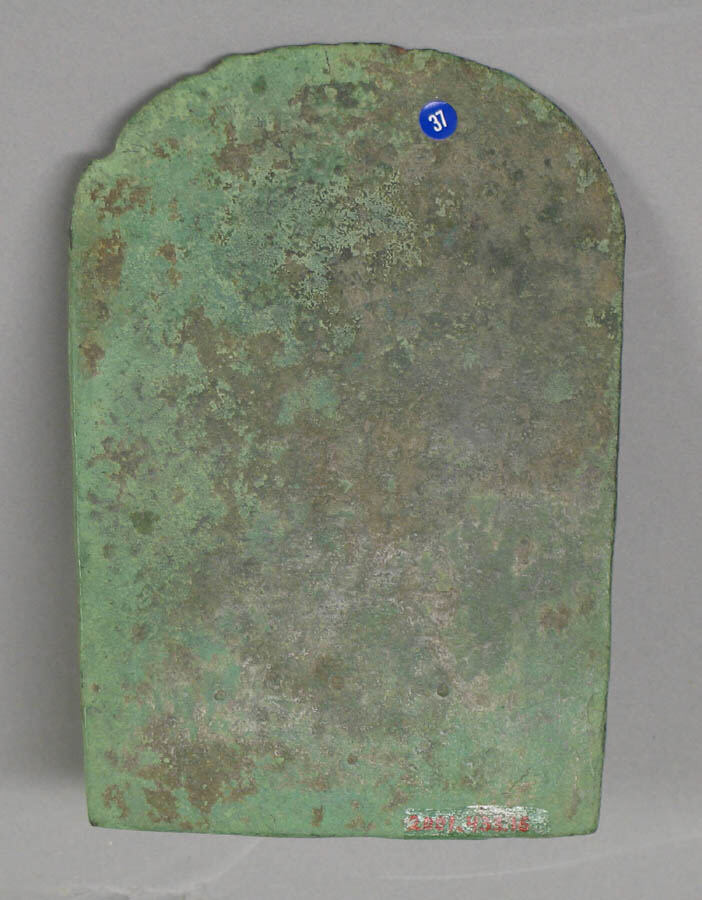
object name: ax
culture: indian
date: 1500-500 BCE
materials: copper